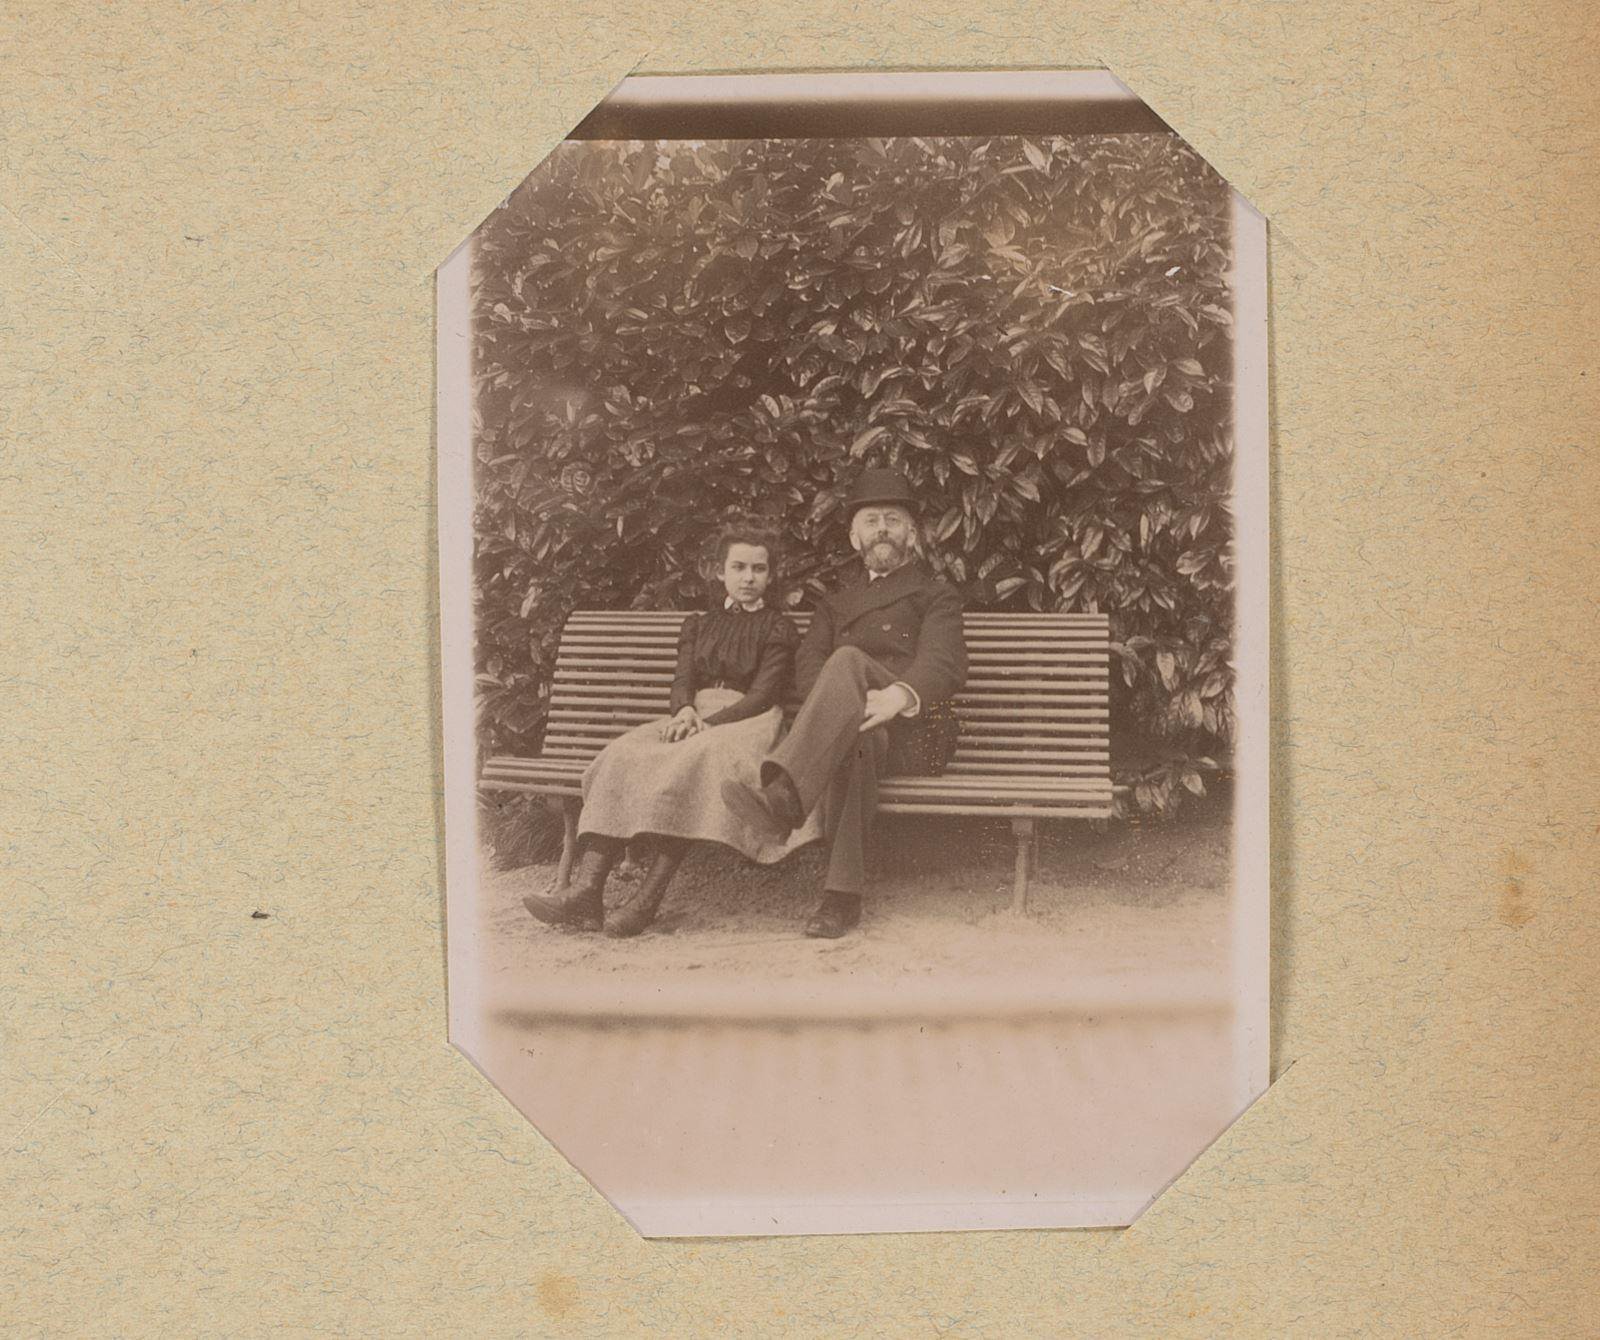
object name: album leaf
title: Portret van een man en een meisje op een bank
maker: Anonymous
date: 1897-1900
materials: paper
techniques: gelatin silver print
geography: france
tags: adult man, historical persons, girl (child between toddler and youth), france